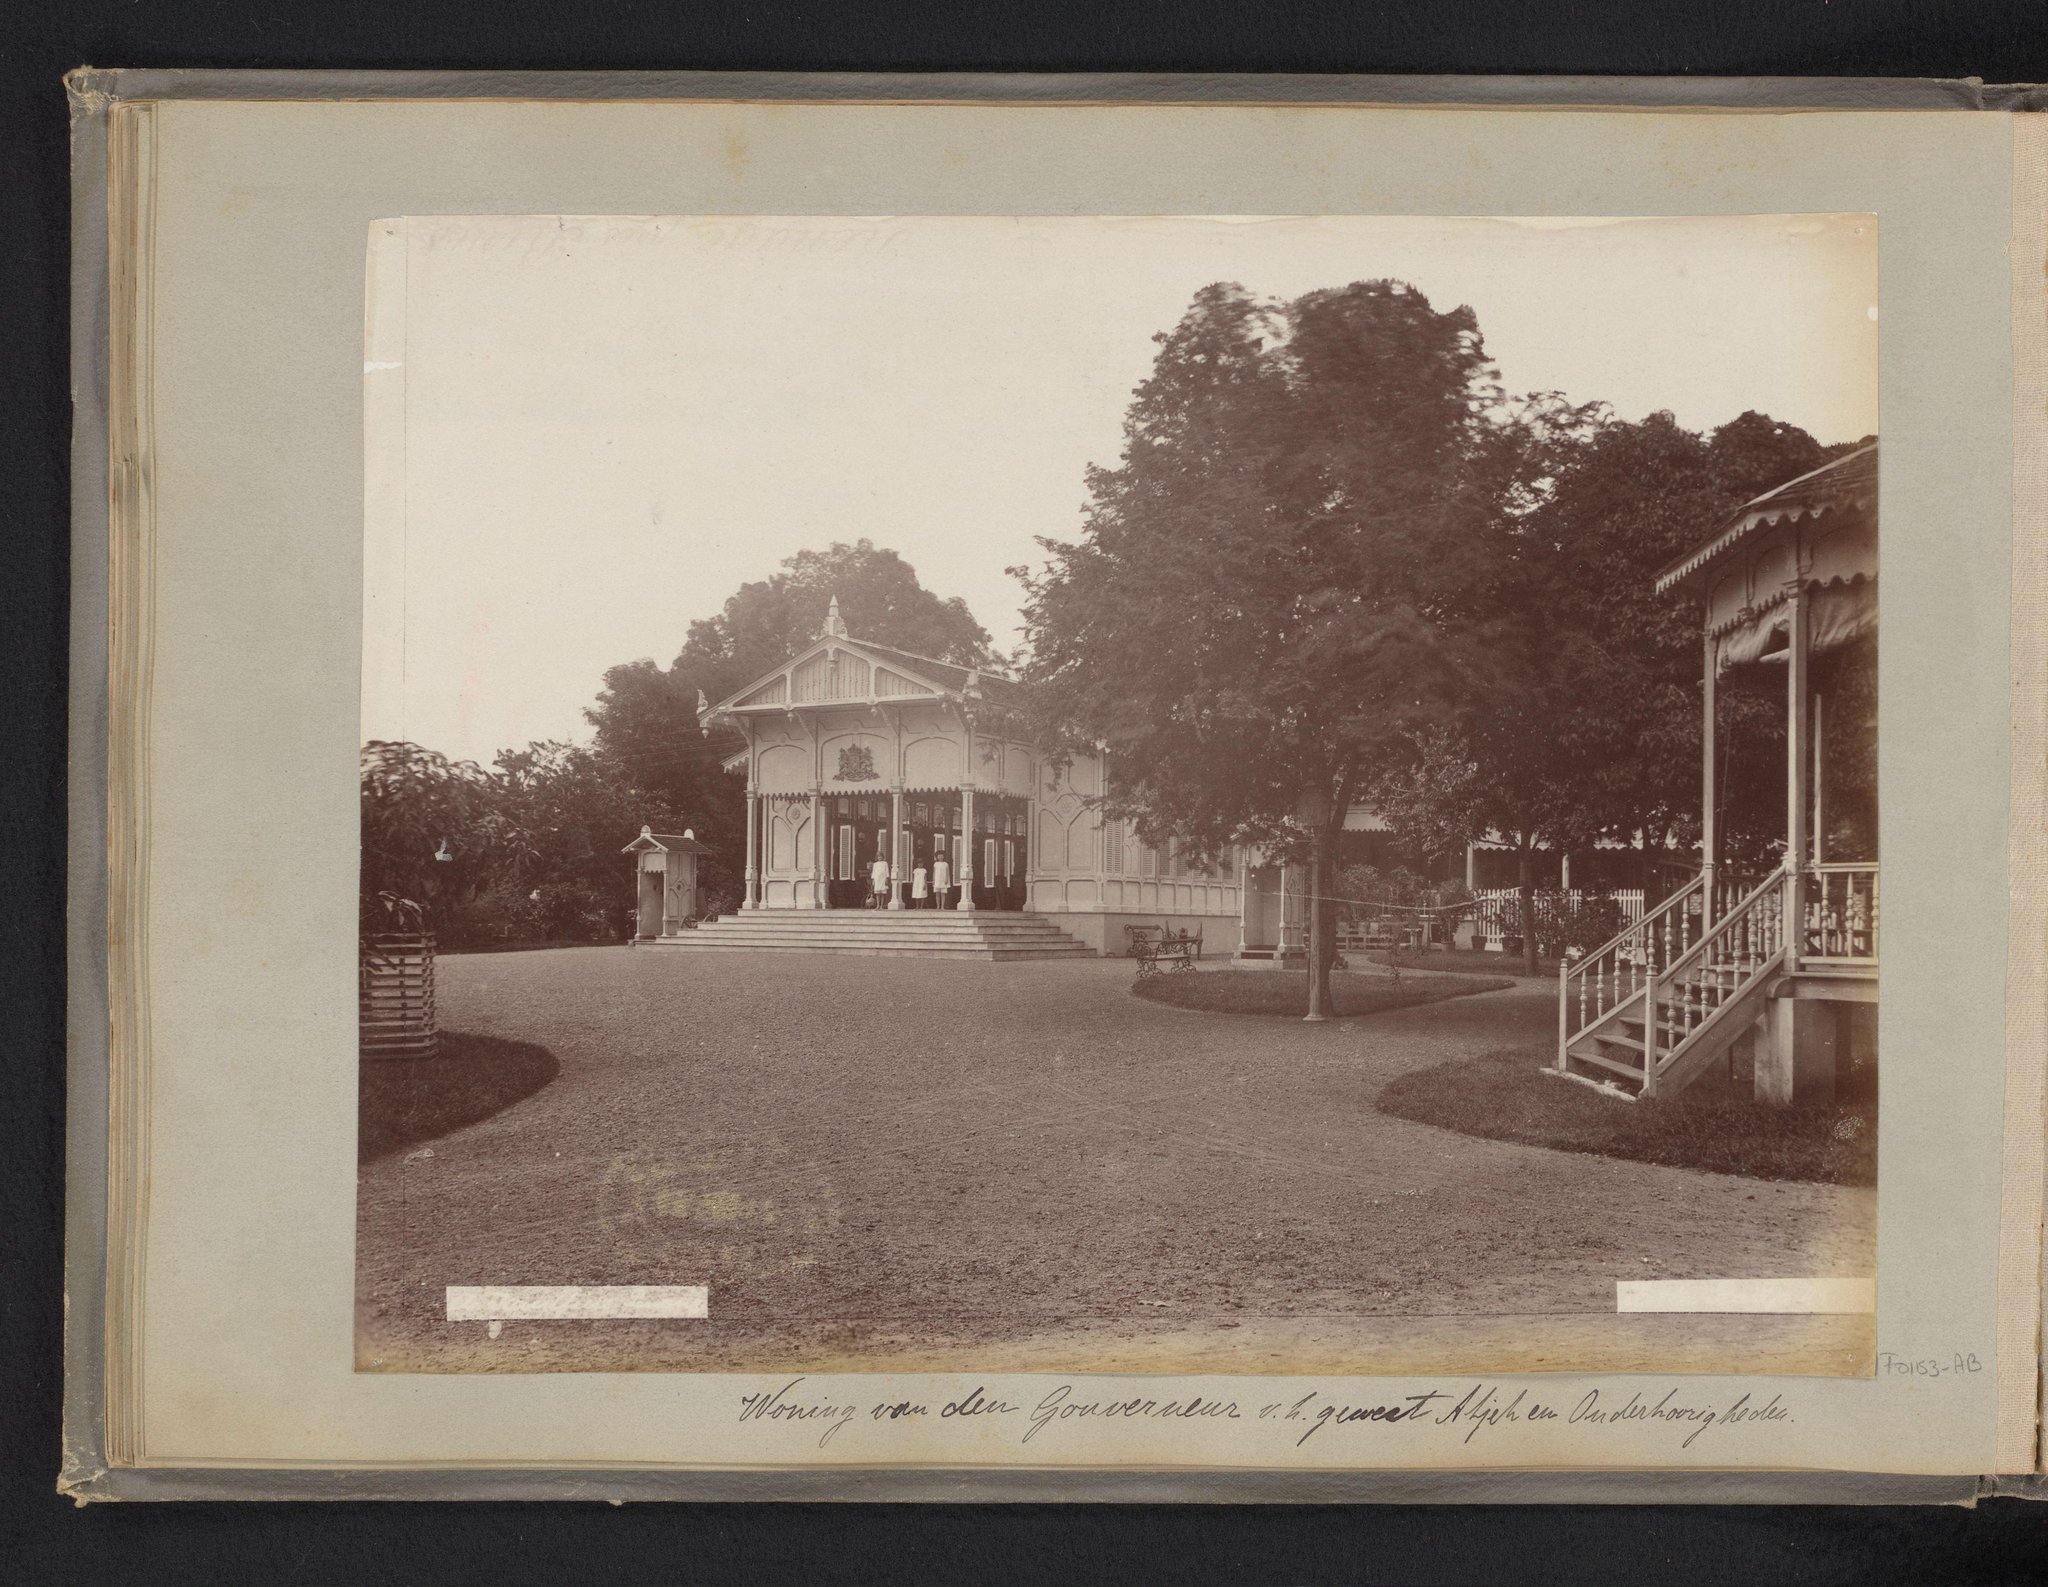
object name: photograph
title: Woning van de Gouverneur van Atjeh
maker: a. kaulfuss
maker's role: fotograaf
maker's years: 1861-1909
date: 1891-1894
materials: photographic support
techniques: albumen print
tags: trees, rural housing, e.g. country-house, villa, cottage